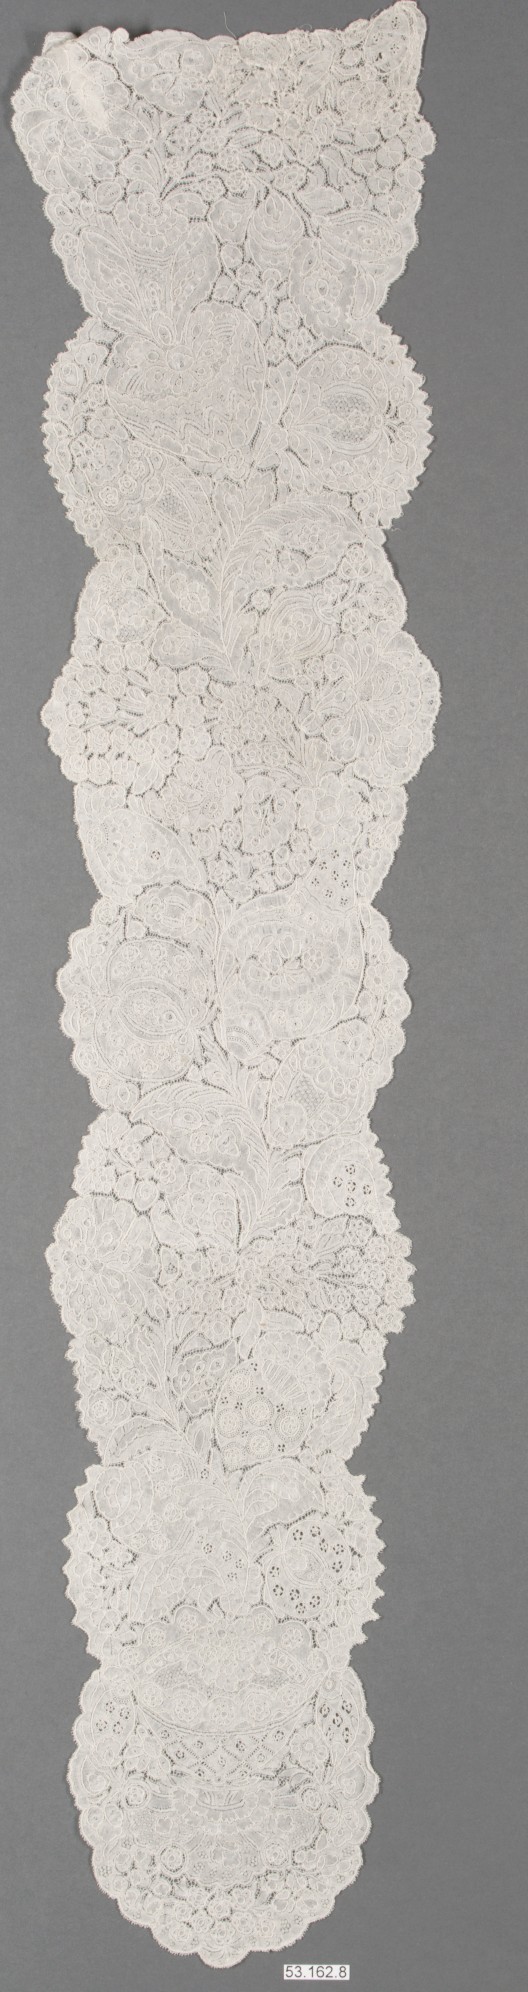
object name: lappet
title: Pair of lappets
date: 1701-1733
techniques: lace